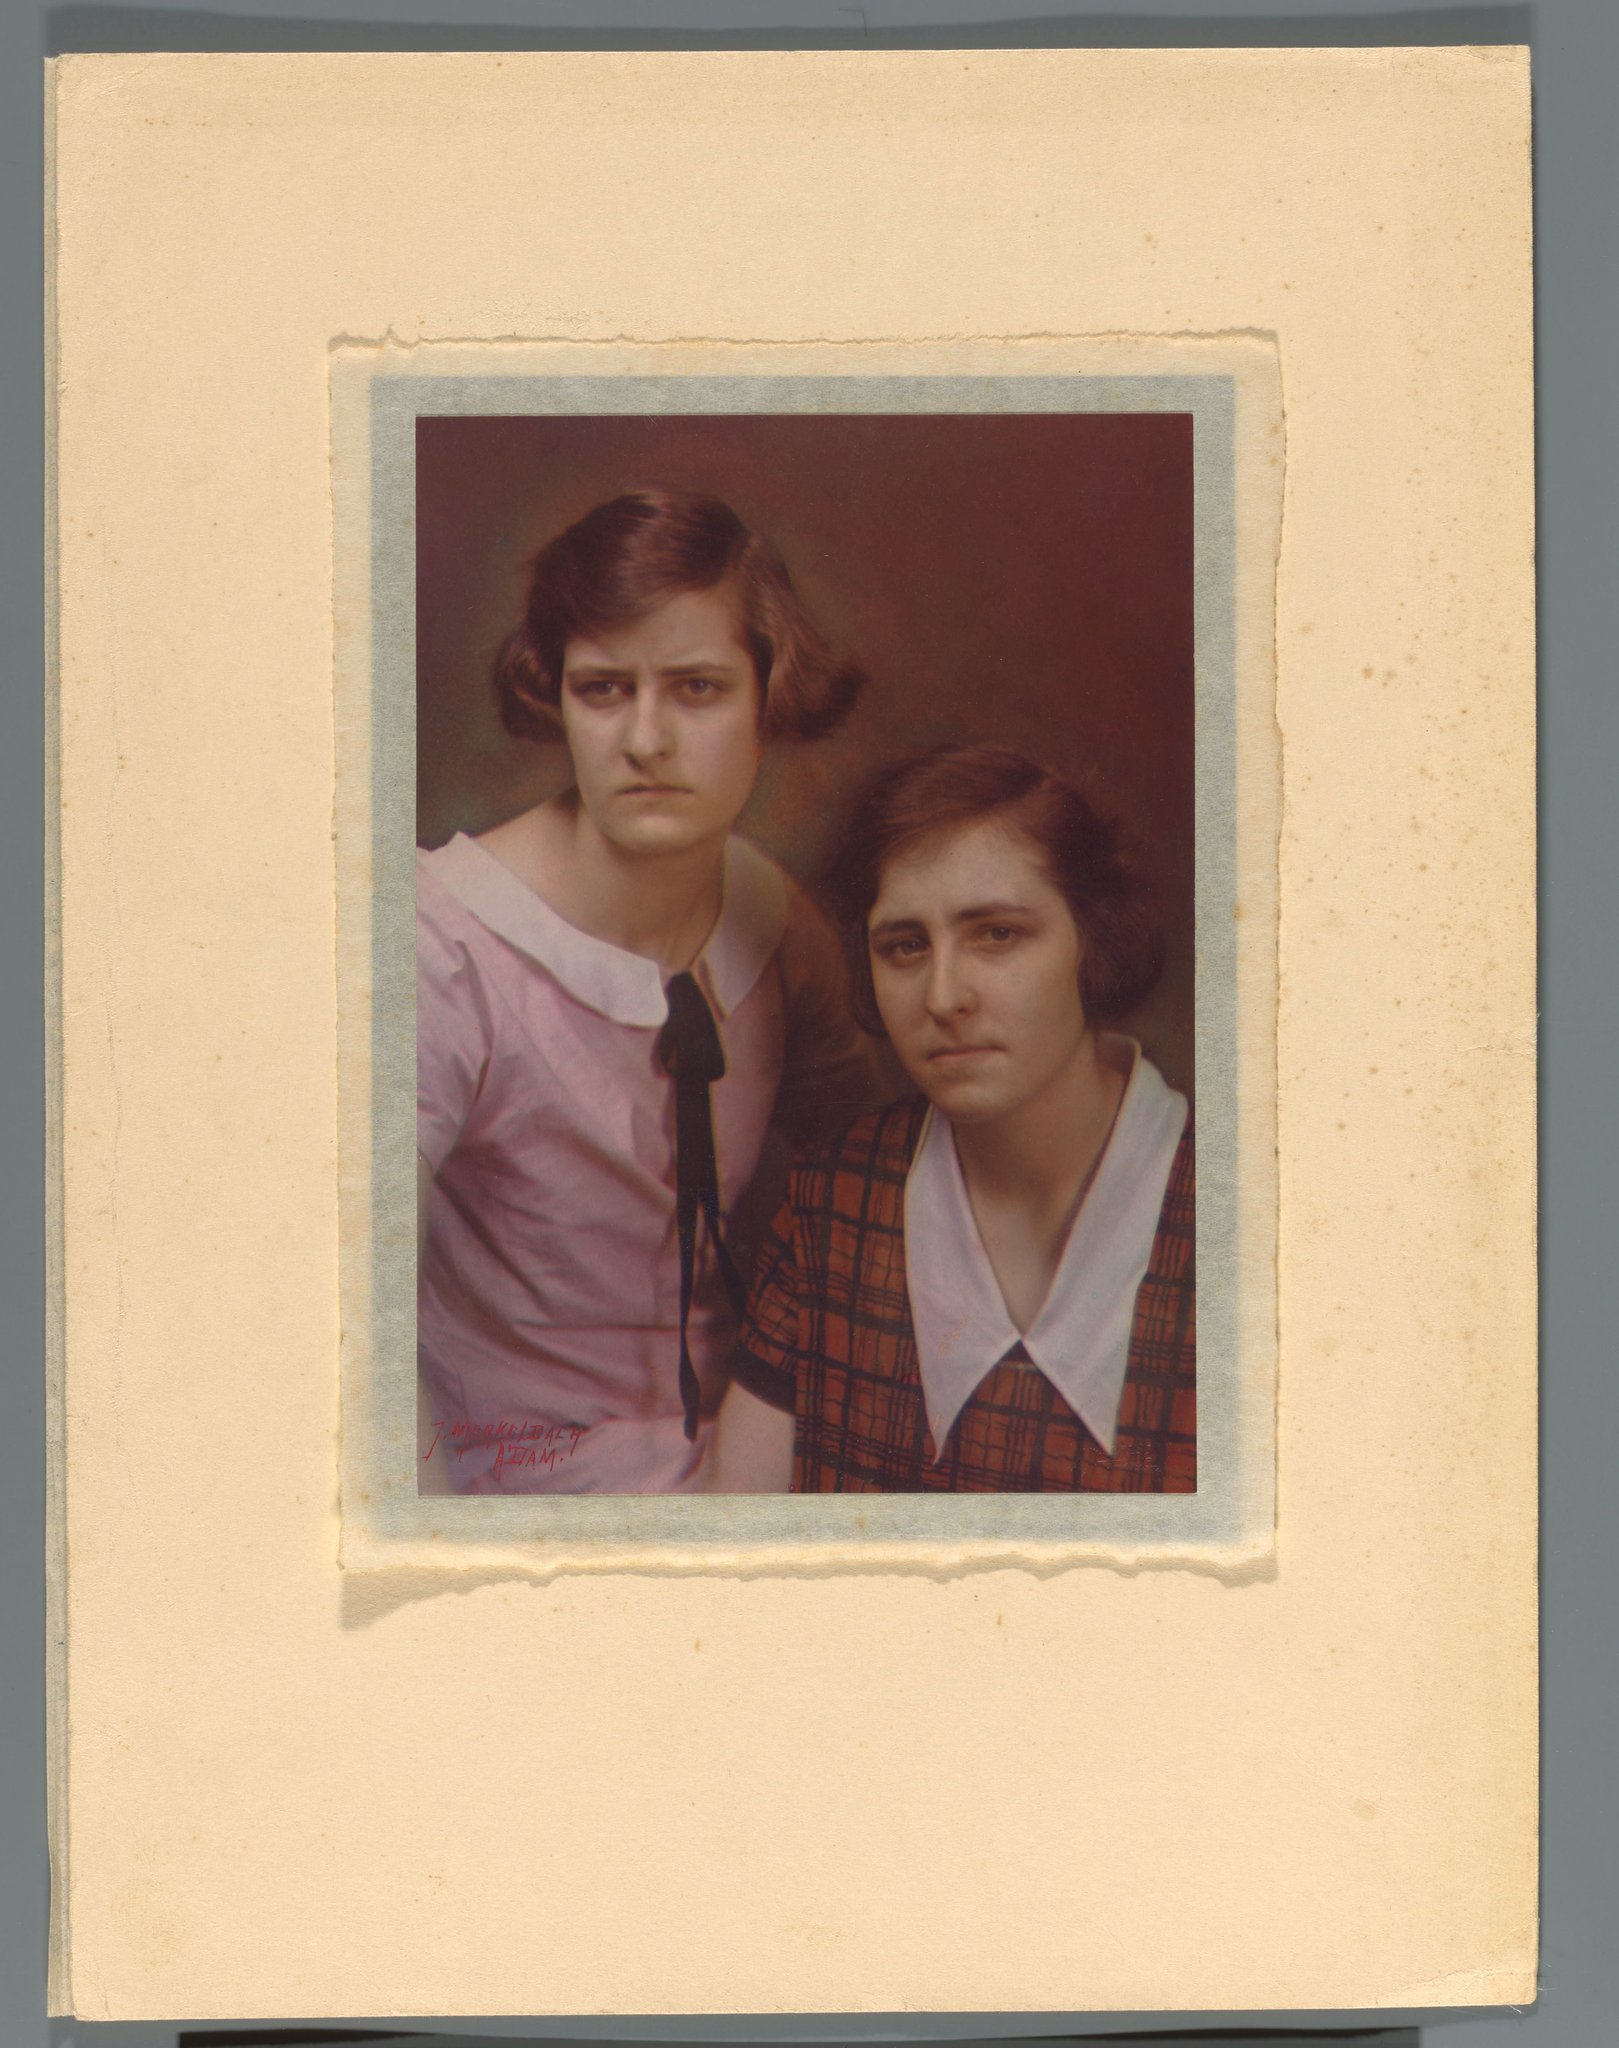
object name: photograph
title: Portret van Mies Rosenboom-Merkelbach en haar zus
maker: jacob merkelbach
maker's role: fotograaf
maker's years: 1877-1942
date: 1920-1930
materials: cardboard, paper, photographic support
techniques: jos-pé print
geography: amsterdam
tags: historical persons (portraits and scenes from the life) - bb - woman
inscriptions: inscription: ‘Mies Roosenboom Merkelbach en zuster’